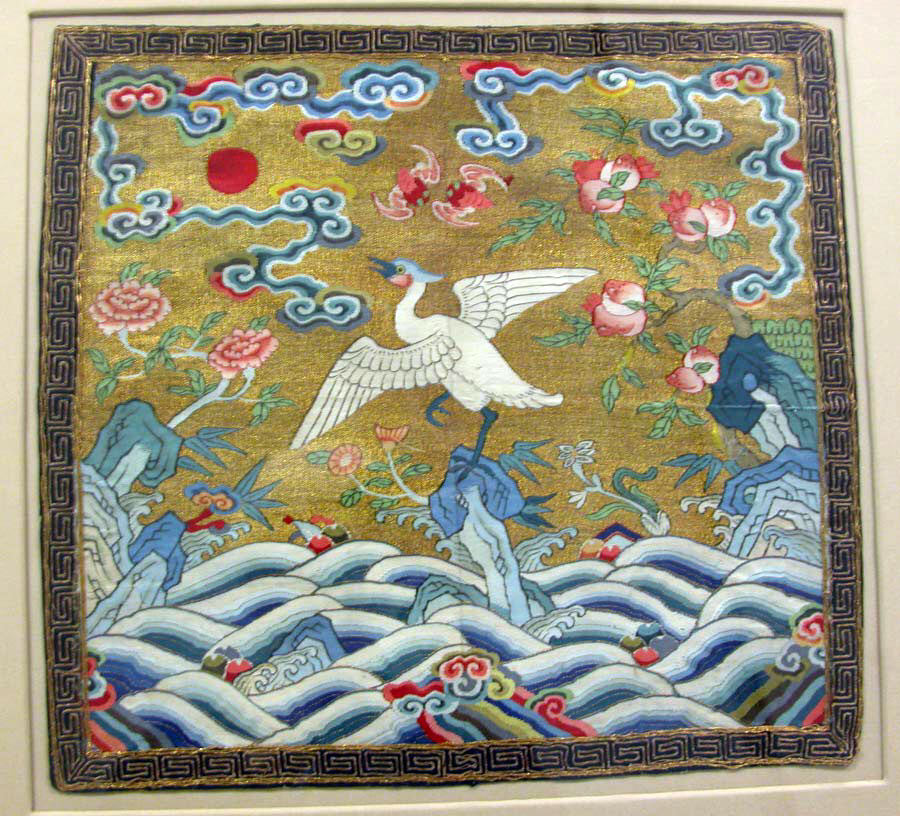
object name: rank badge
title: Rank Badge with Egret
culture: chinese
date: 1767-1800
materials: metal thread, silk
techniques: tapestry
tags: bats,birds